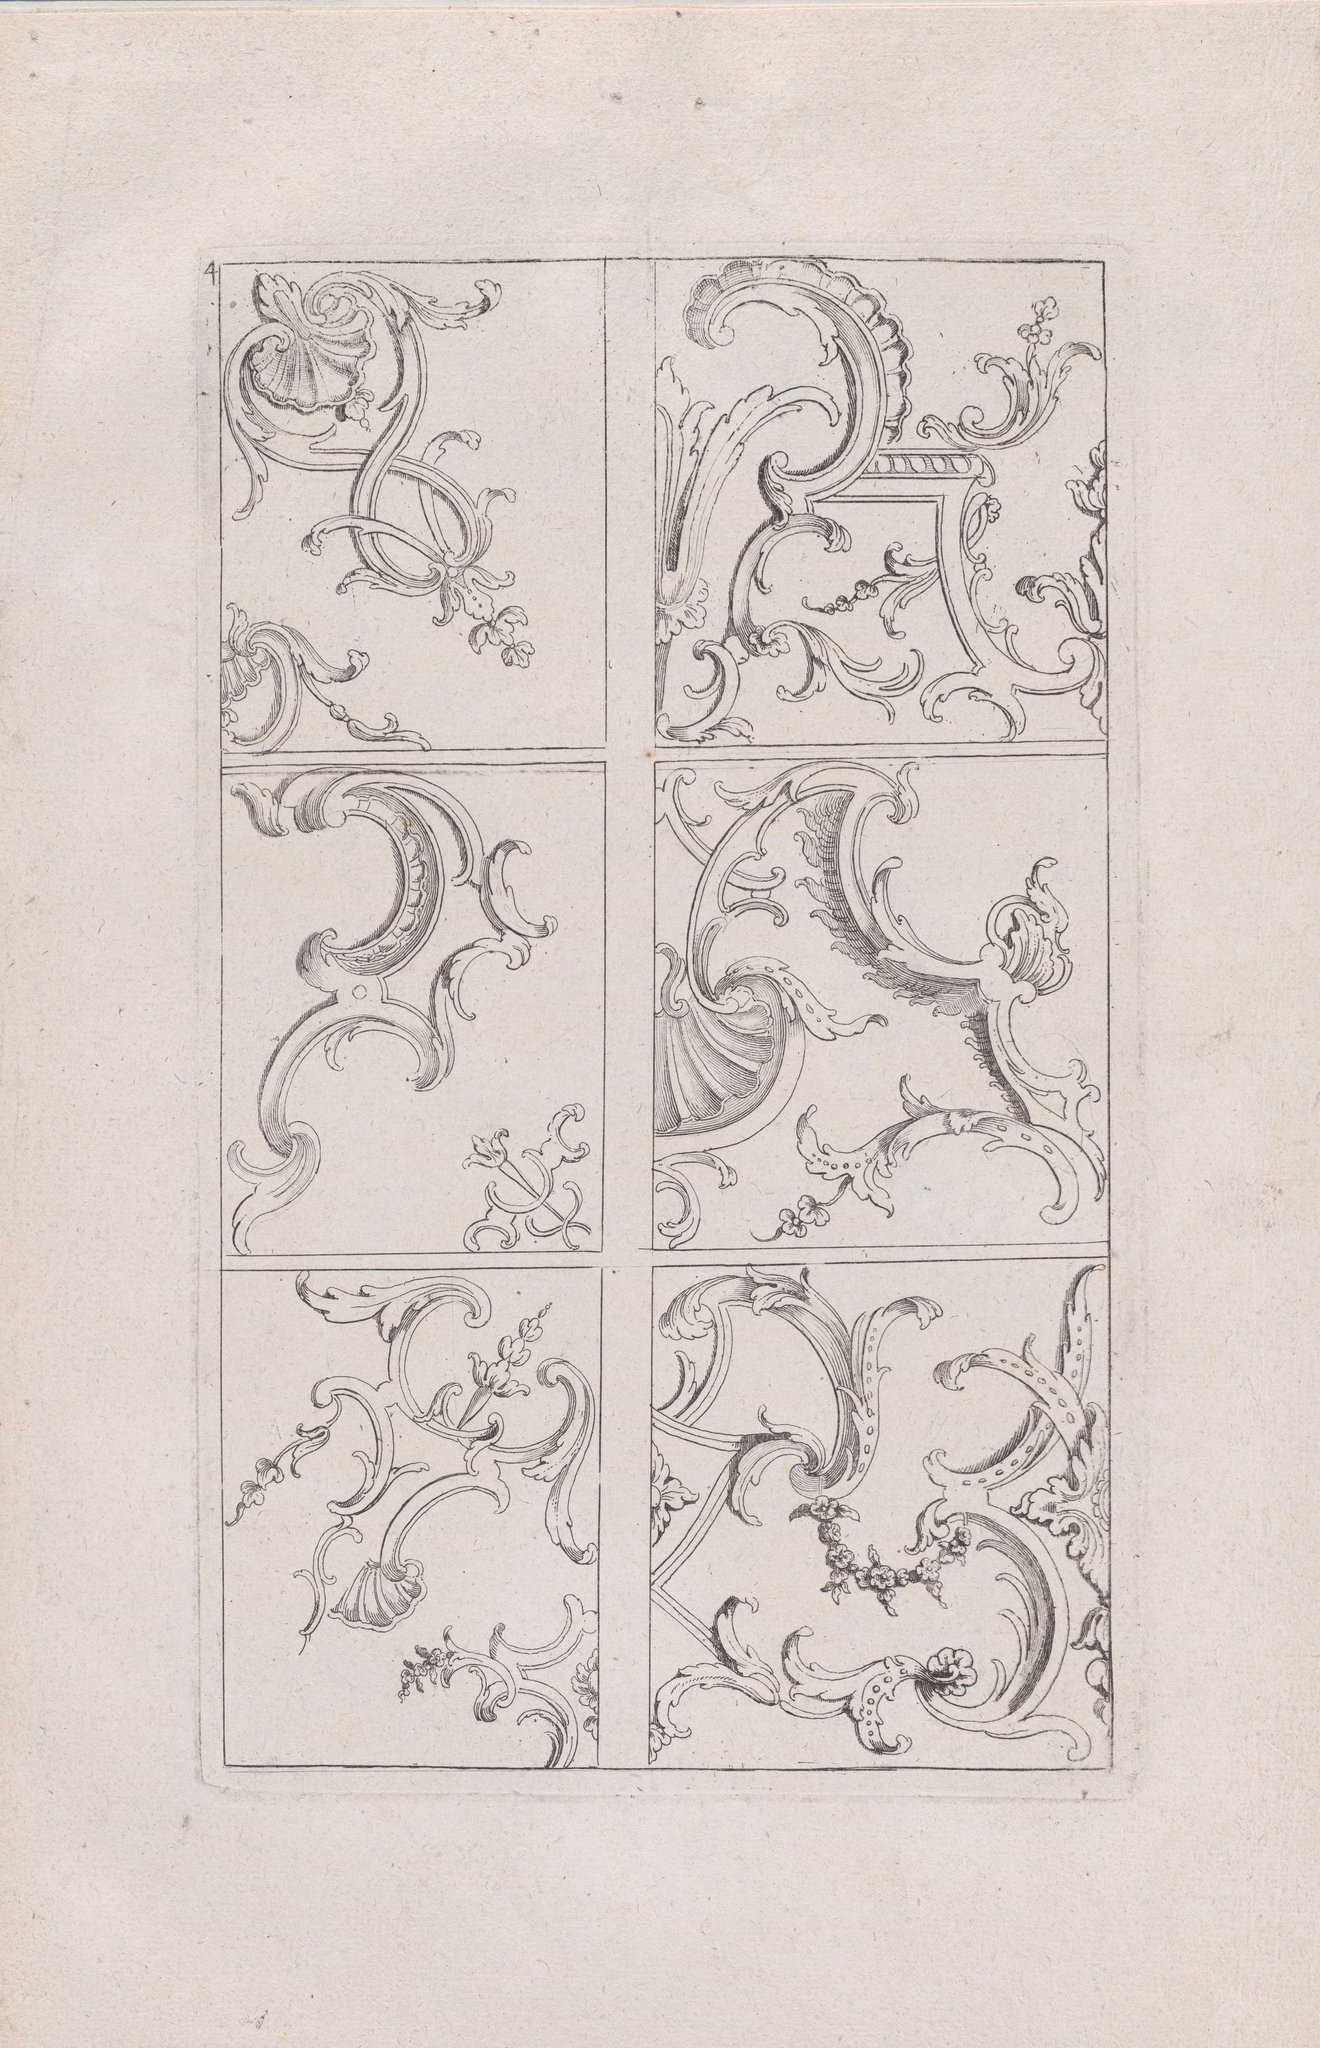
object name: print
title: Plate 4, from "Livre Nouveau de Prinsipes D'Ornemens, tres facil. Pour apprendre a Dessigner"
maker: nicolas guérard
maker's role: artist and publisher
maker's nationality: french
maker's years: 1648-1719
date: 1715-1725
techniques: engraving